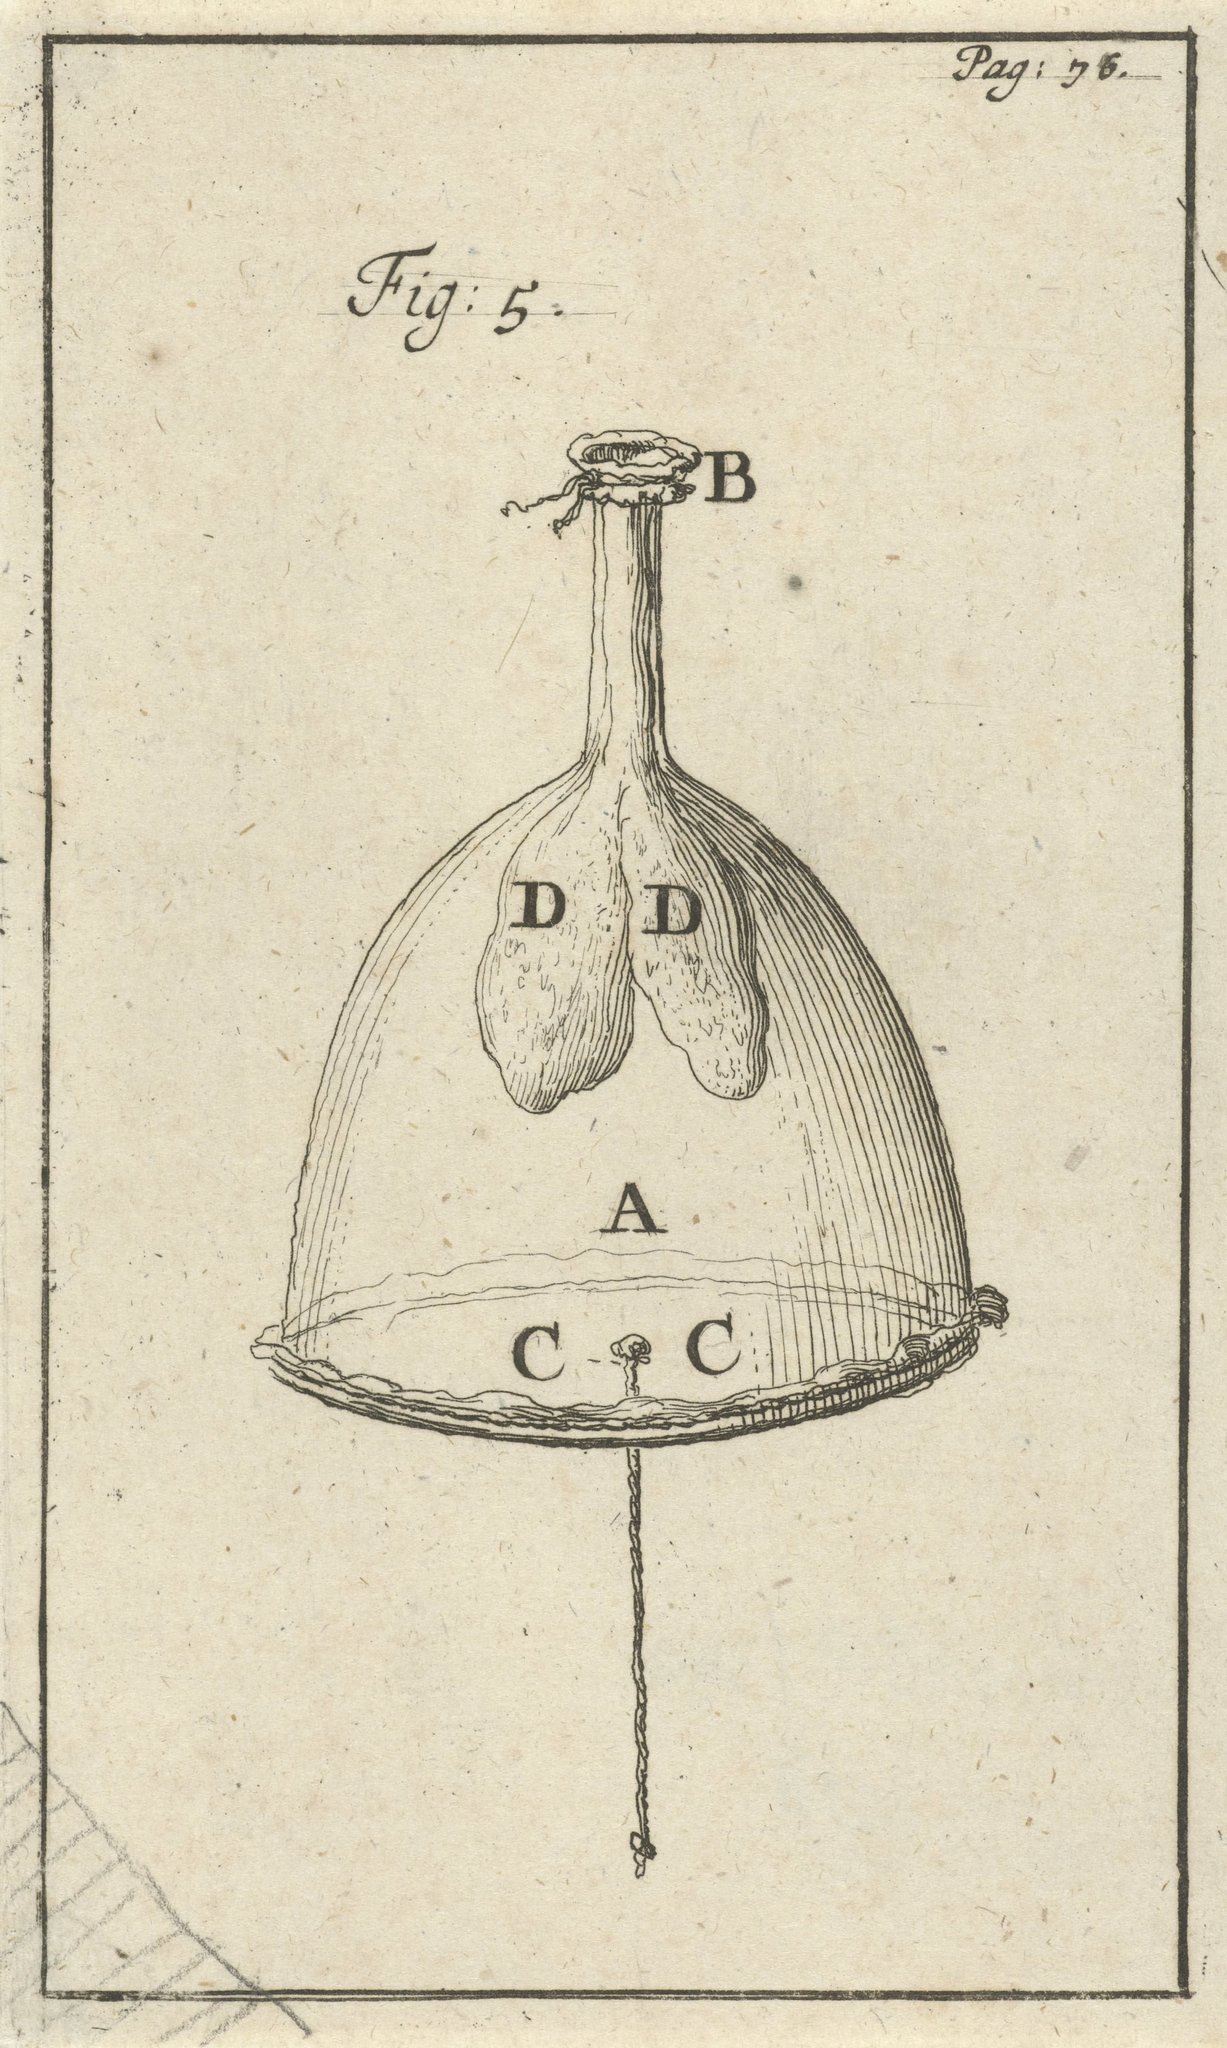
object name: print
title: Luchtpomp met blazen, fig. 5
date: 1683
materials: paper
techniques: etching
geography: amsterdam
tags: medical research, branches of medicine (+ scientific research)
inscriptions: collector's mark: Lugt 2228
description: Illustratie opgenomen in: Blankaart, Stephanus. De Kartesiaanse academie ofte Institutie der medicyne. Amsterdam: Jan Claesz ten Hoorn, 1683, p. 75.